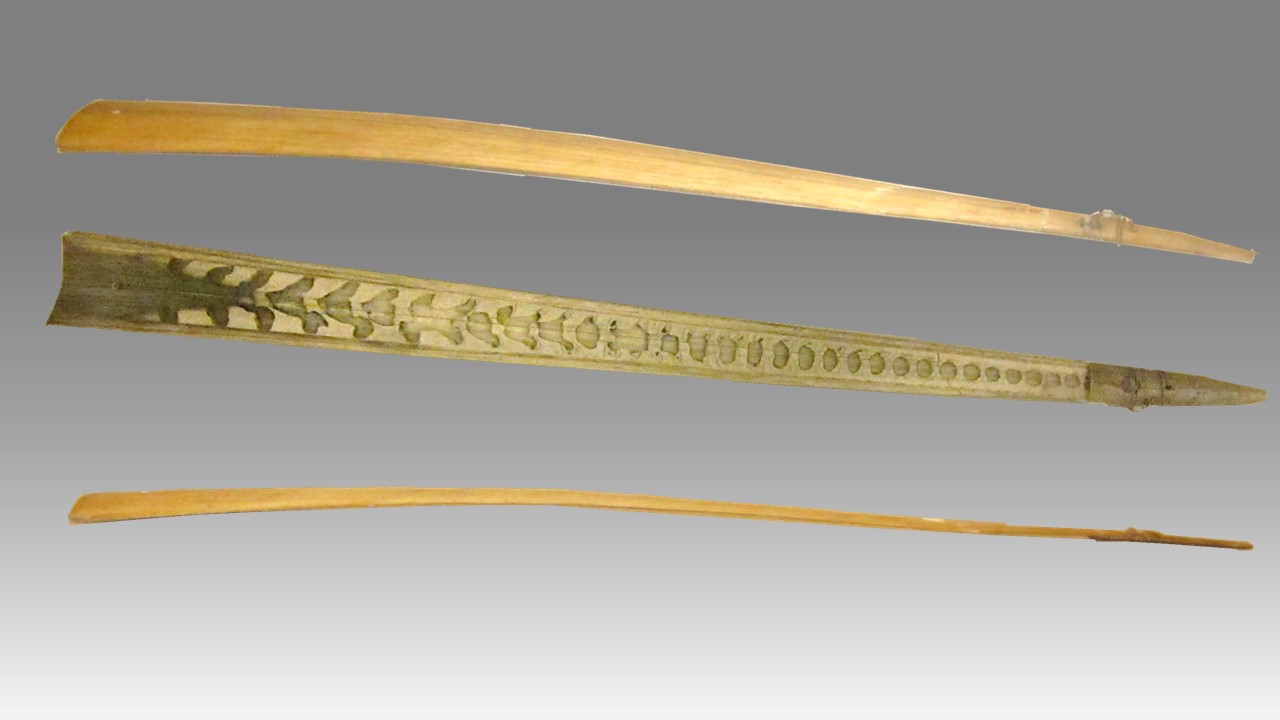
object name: ichigen kin 一絃琴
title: Ichigen-kin (一絃琴)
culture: japanese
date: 1801-1900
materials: bone, silk, wood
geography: japan